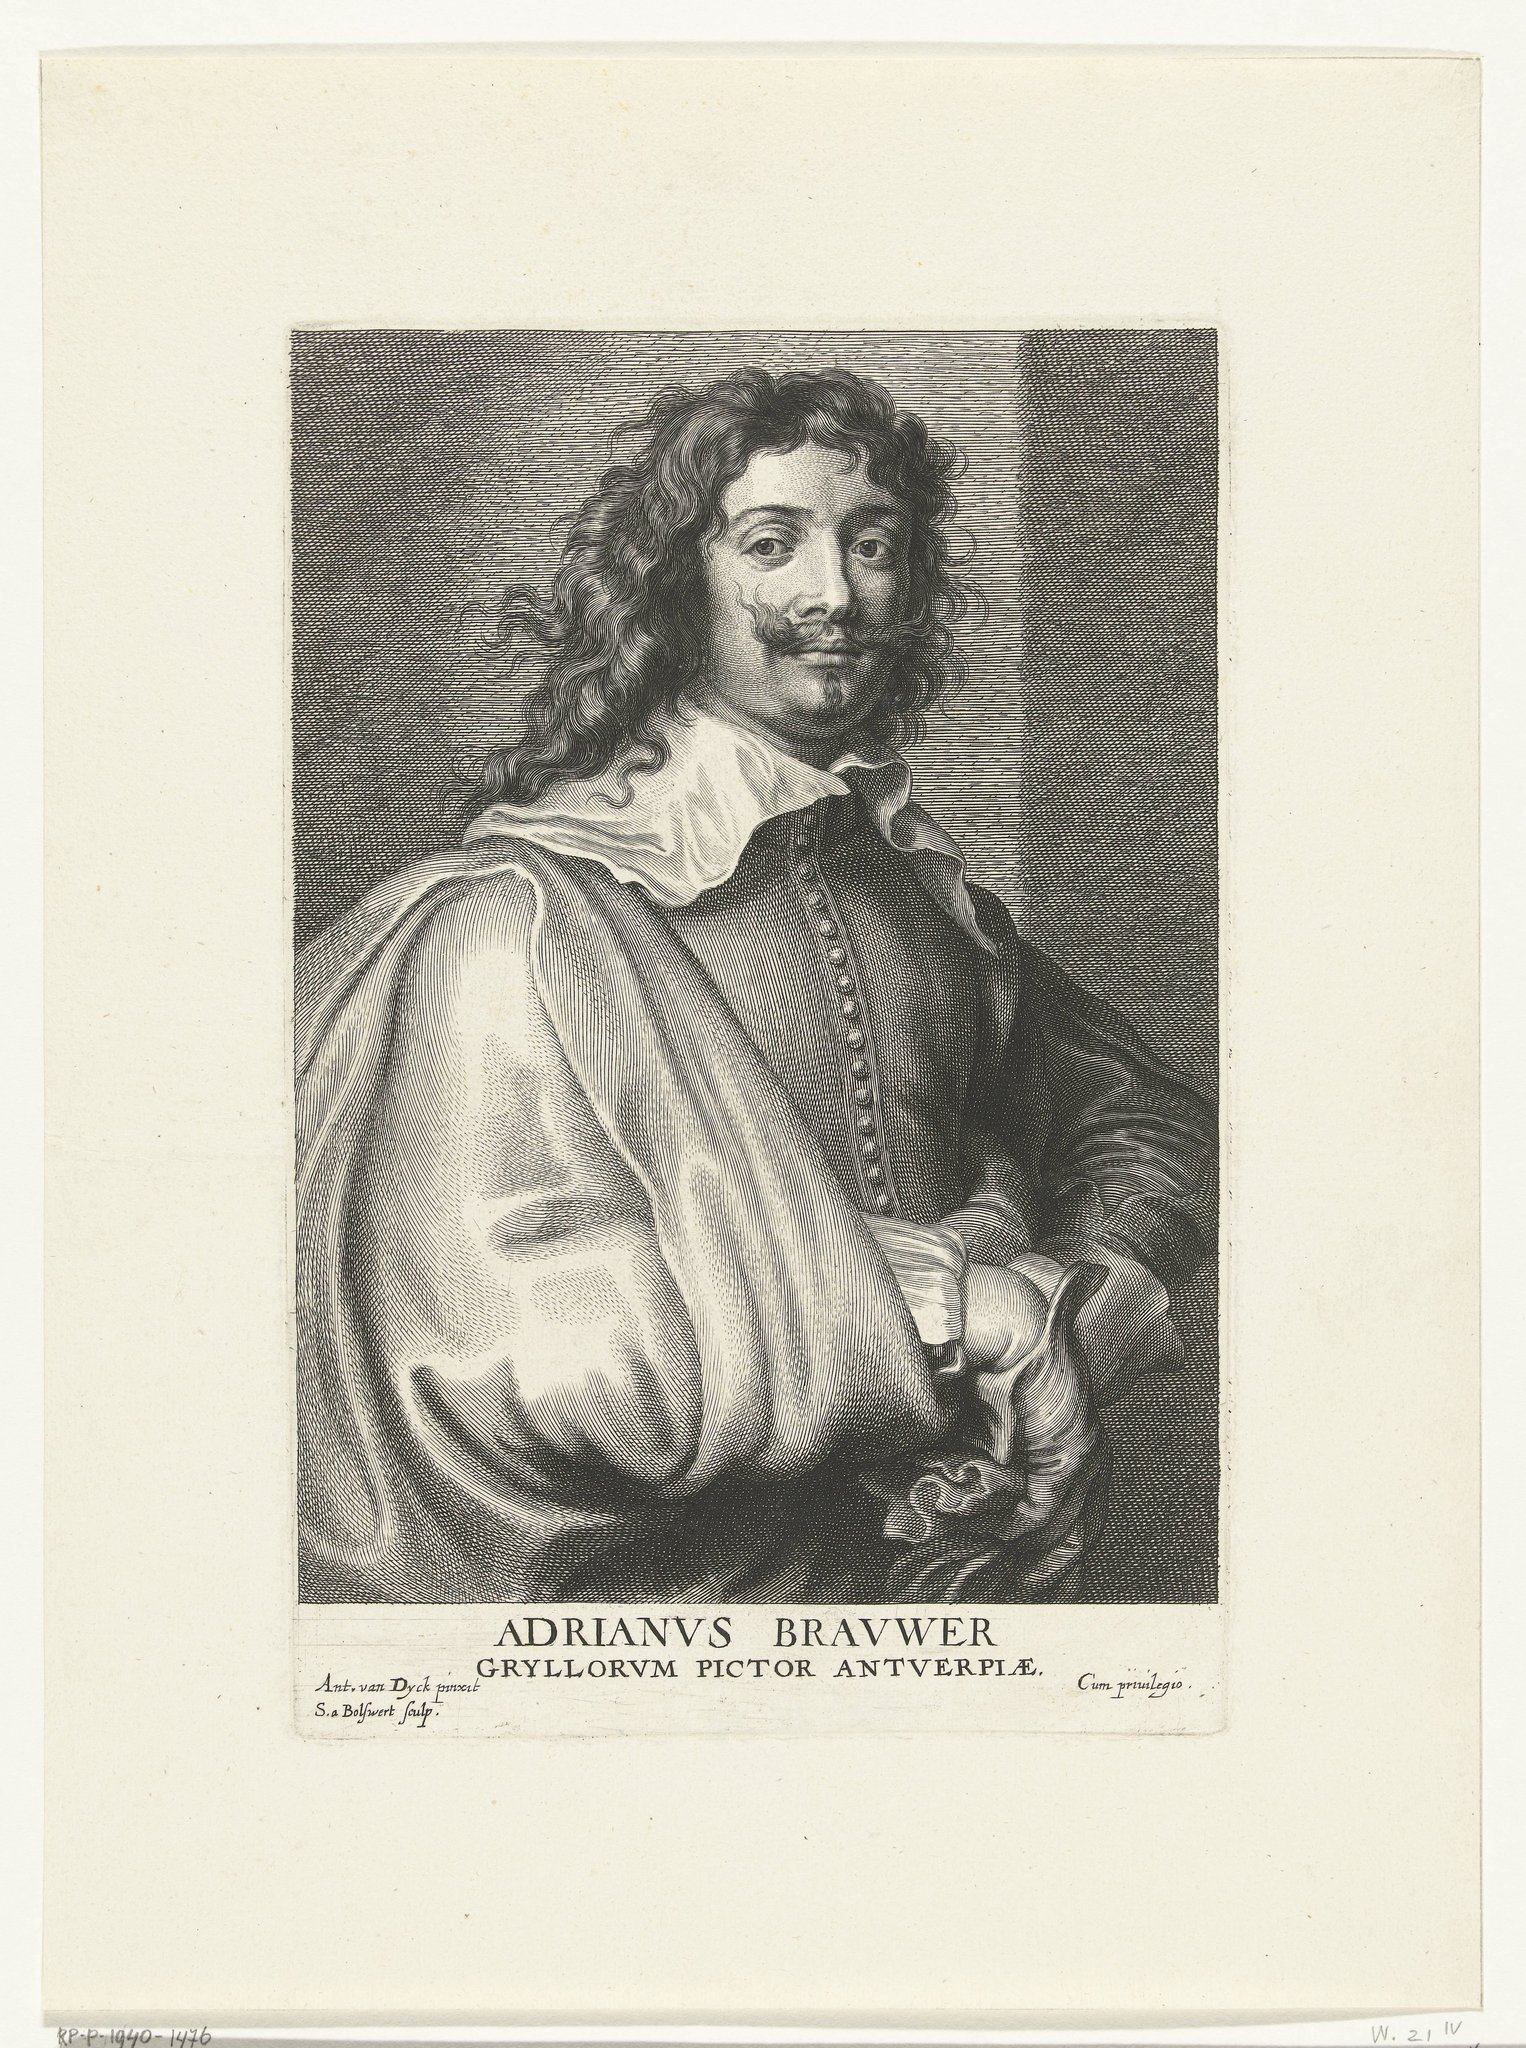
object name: print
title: Portret van schilder Adriaen Brouwer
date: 1596-1659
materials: paper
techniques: engraving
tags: antwerp, painter, print maker, draughtsman, adriaen brouwer, portrait, self-portrait of painter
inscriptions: collector's mark: Lugt 2760, collector's mark: Lugt 2166, collector's mark: Lugt 2228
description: Prent naar schilderij van Anthony van Dyck. Behoort tot de Verzameling Gerritsen, kunstenaarsportretten